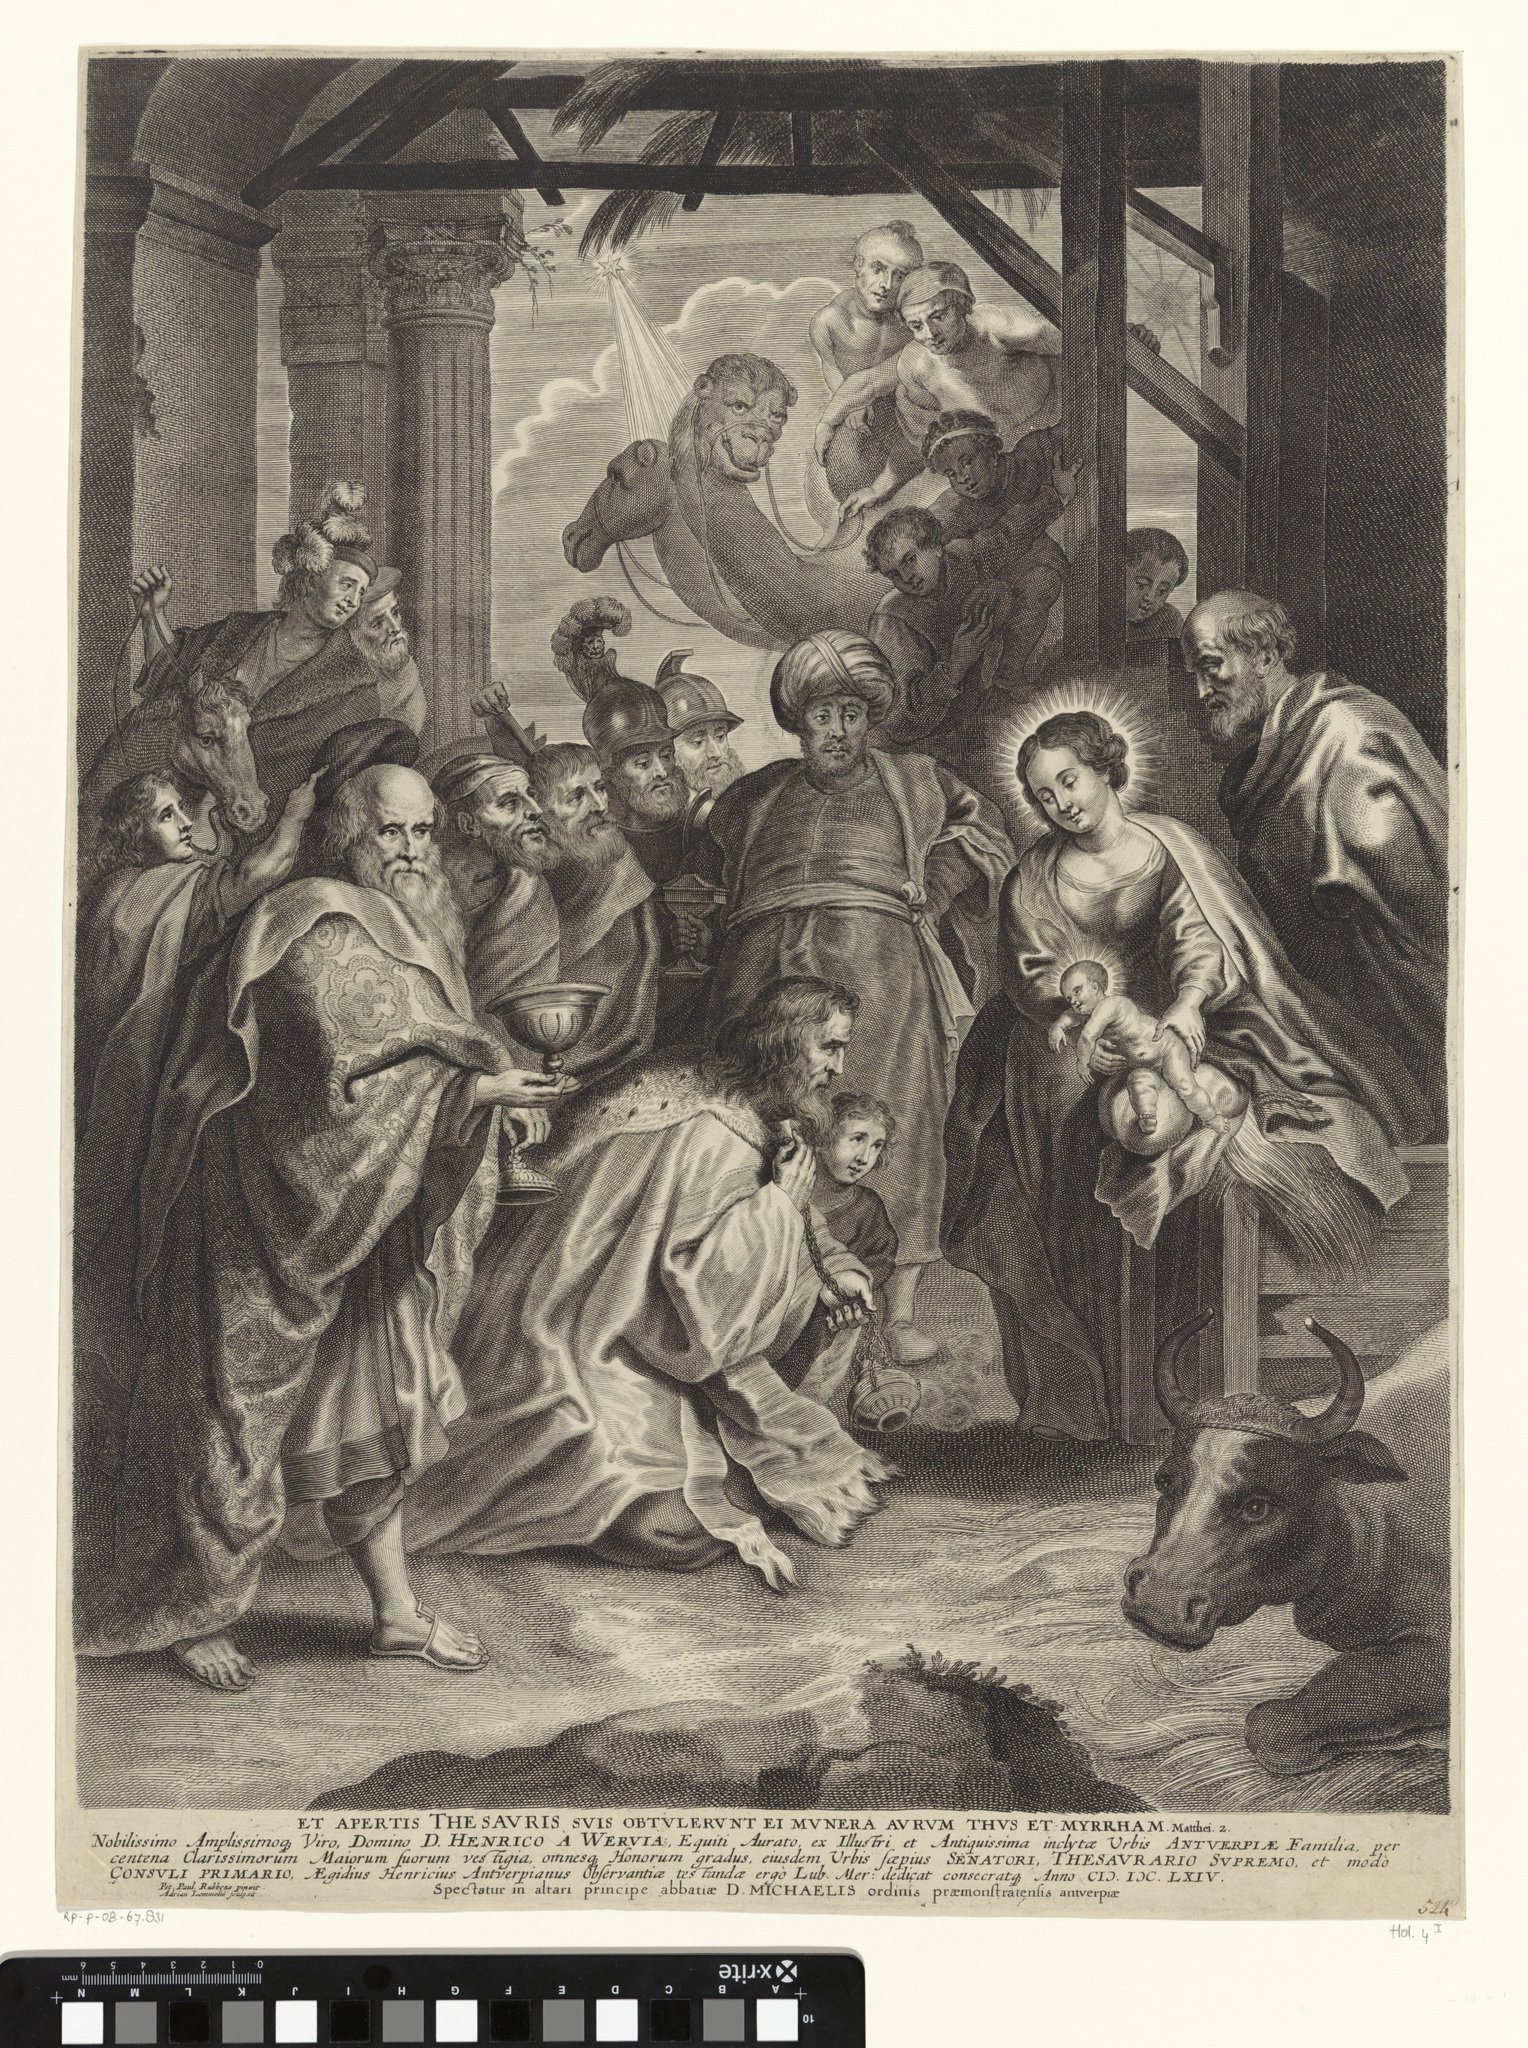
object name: print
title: Aanbidding der koningen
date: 1630-1677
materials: paper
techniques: engraving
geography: antwerp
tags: adoration of the kings: the wise men present their gifts to the christ-child (gold, frankincense and myrrh)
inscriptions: number: ‘524’, collector's mark: Lugt 240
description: Maria en Jozef tonen het Christuskind aan de drie koningen. De drie bieden het kind hun geschenken aan. Leden van hun gevolg kijken toe.